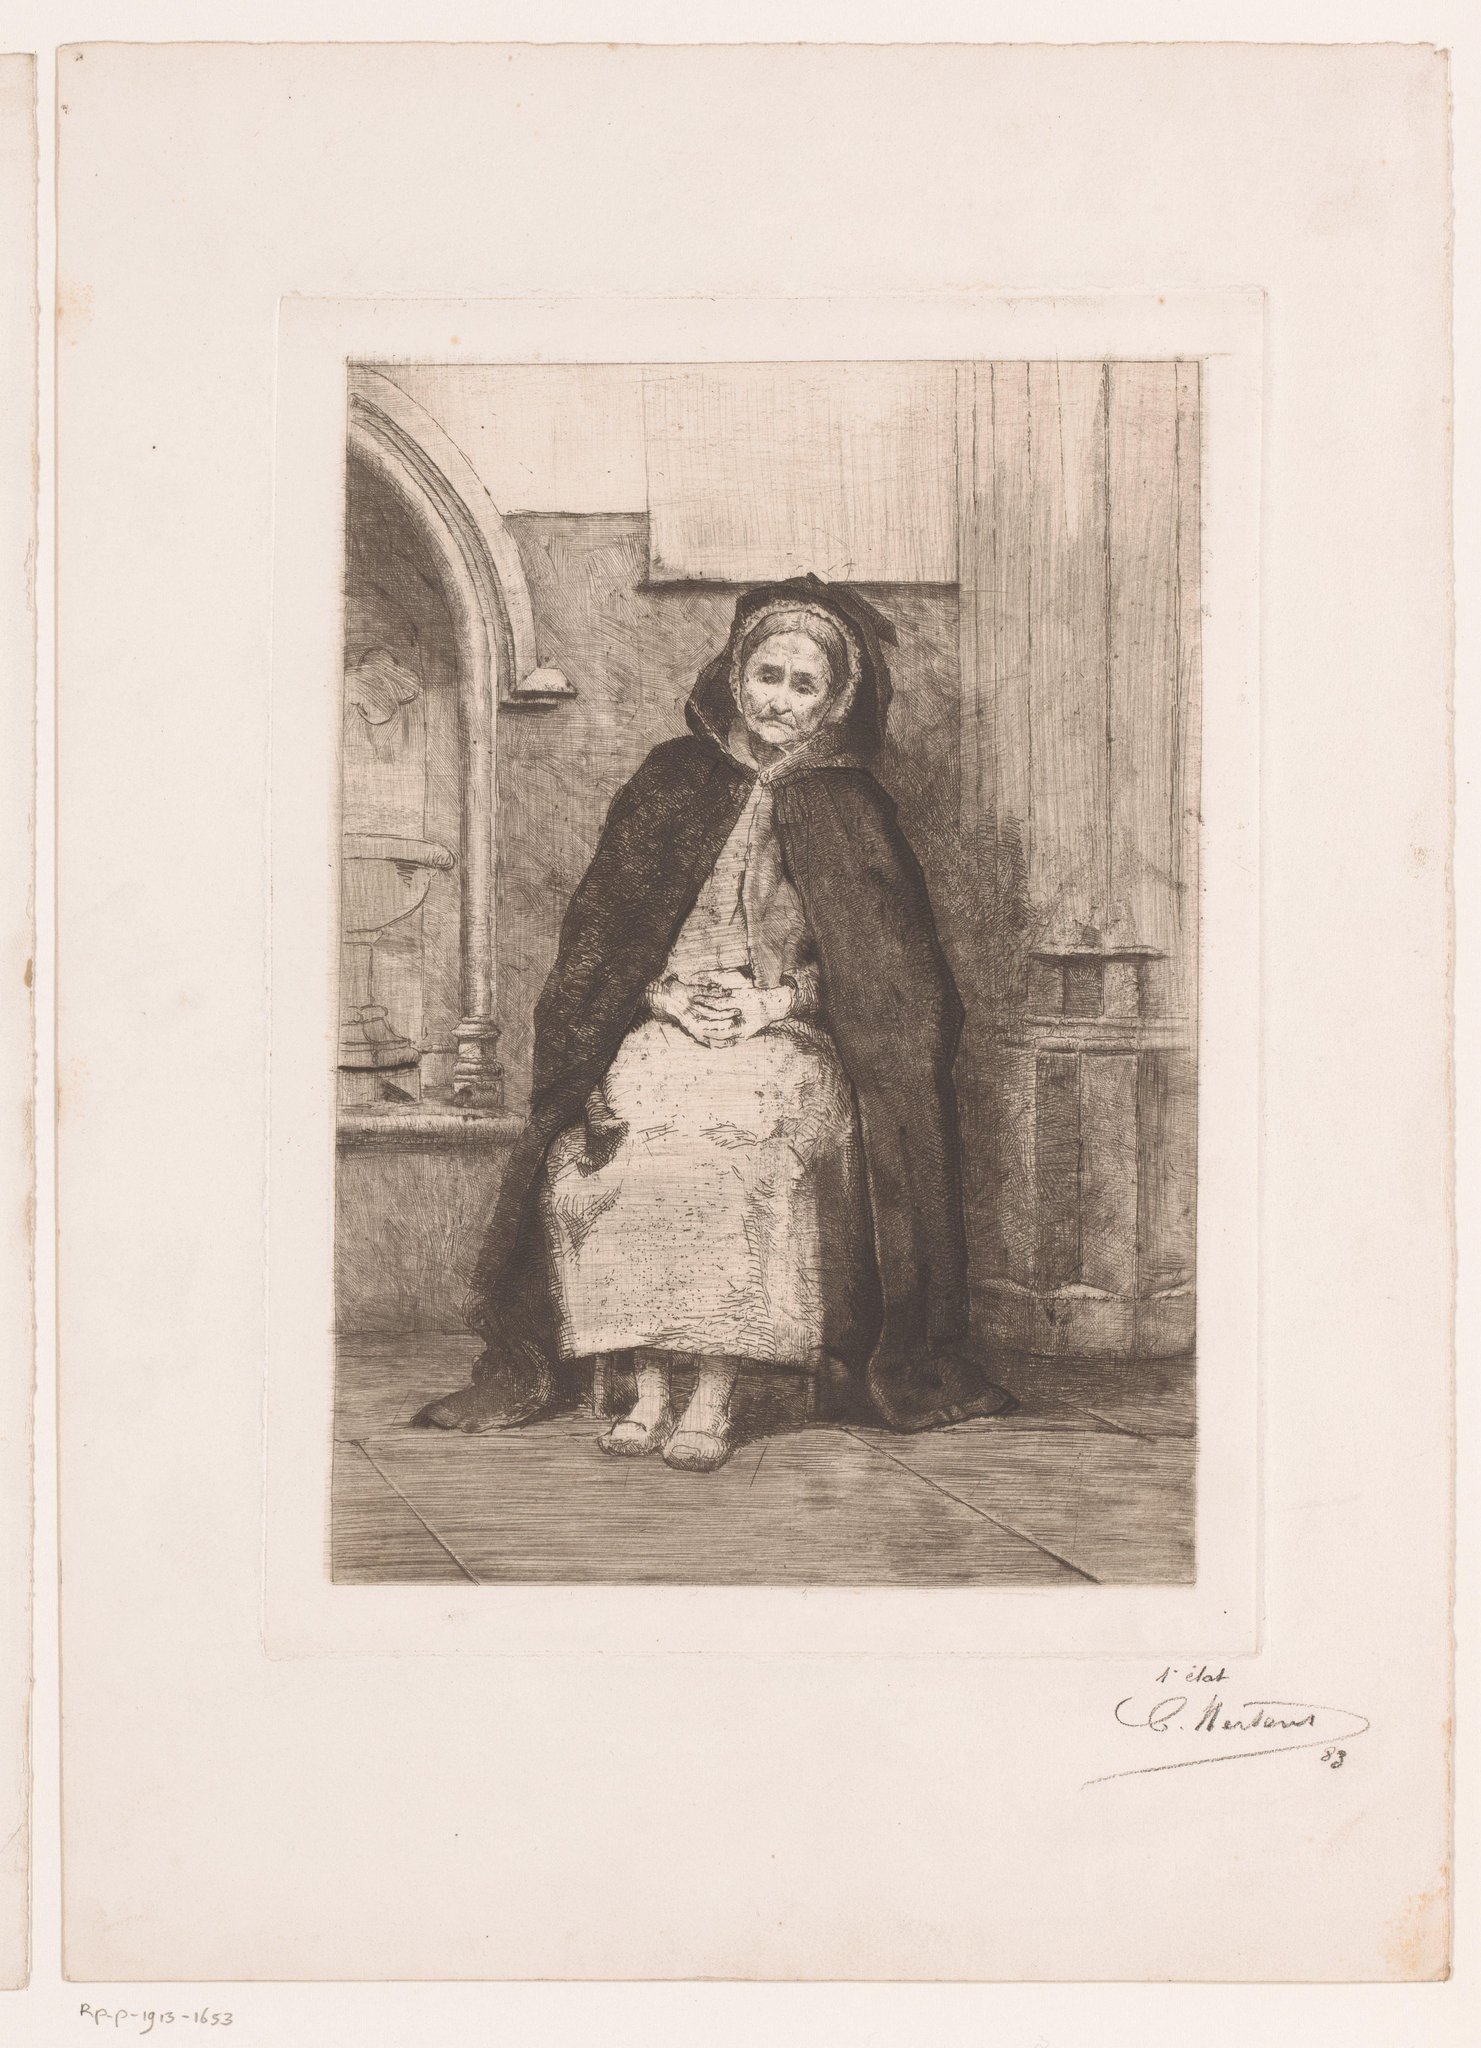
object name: print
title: Oude bedelende vrouw gezeten voor de basiliek van Onze-Lieve-Vrouw van Scherpenheuvel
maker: charles mertens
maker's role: print maker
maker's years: 1865-1919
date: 1883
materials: paper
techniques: drypoint, etching, intaglio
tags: place of pilgrimage, sacred place, old woman, beggar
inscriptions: collector's mark: Lugt 2228, inscription: ‘1e état’